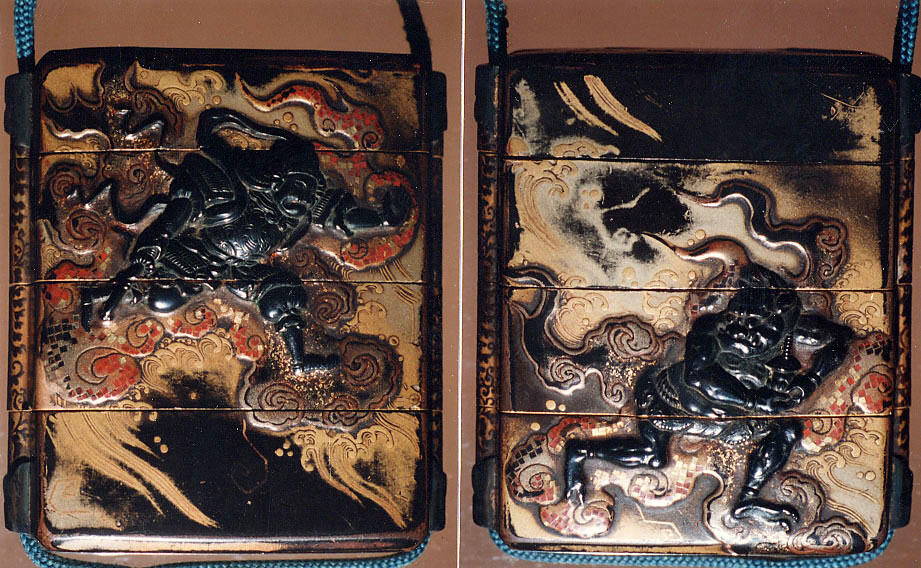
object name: inrō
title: Case (Inrō) with Design of Bishamon (or Idaten) Pursuing an Onî (Demon) on Clouds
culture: japanese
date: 1601-1700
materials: gold, lacquer, metal, silver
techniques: fundame, hiramakie, roiro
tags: demons